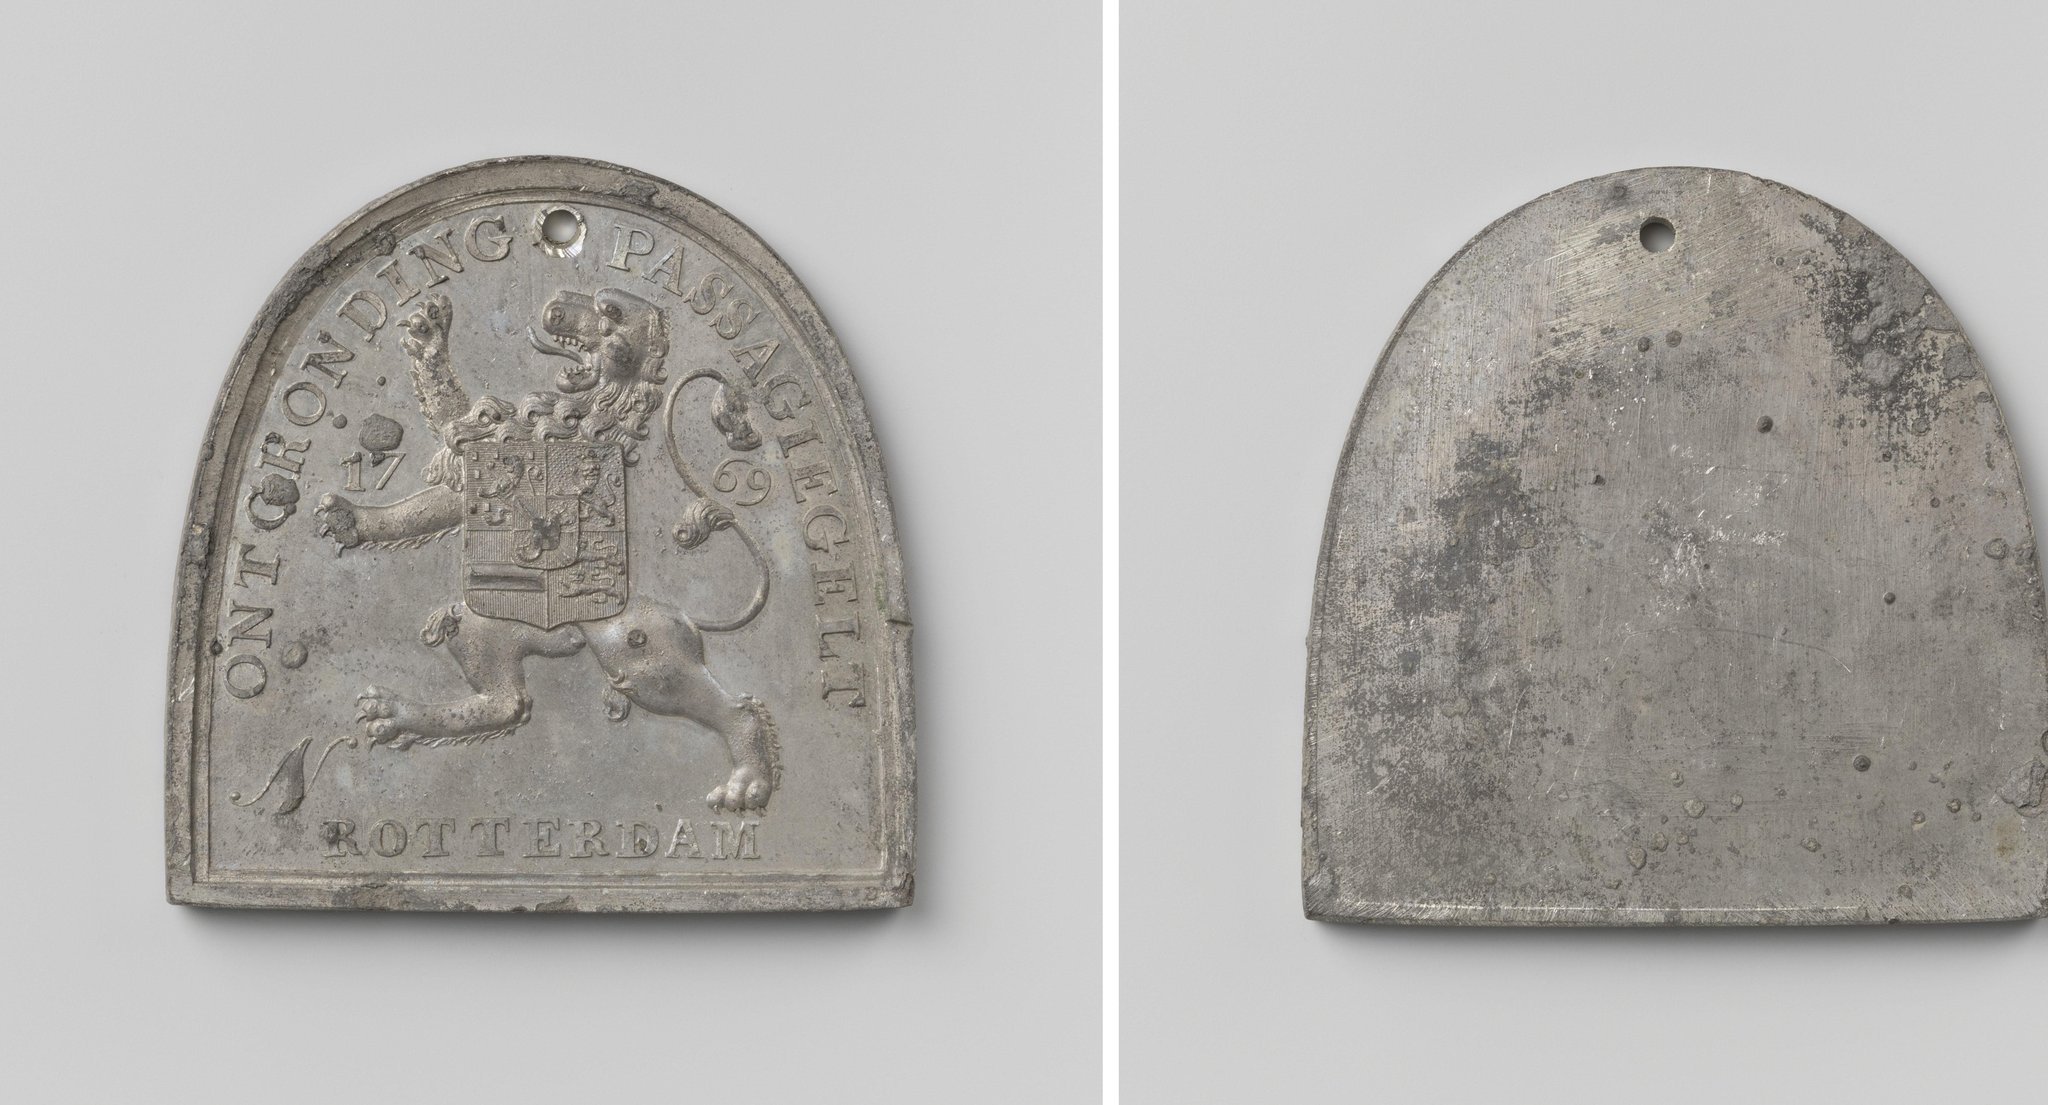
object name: ontgrondingspenning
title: Ontgronding te Rotterdam, penning bedoeld als bewijs voor turfdragers, -vullers of -tonners om turf in te mogen voeren uit de nieuw ontgronde venen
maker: Anonymous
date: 1769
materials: lead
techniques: casting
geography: rotterdam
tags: rotterdam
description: Eenzijdige loden penning met ronde boven- en rechthoekige onderzijde, en gat erin. Voorzijde: staande leeuw met wapenschild op borst tussen jaartal binnen omschrift. Keerzijde: blanco.